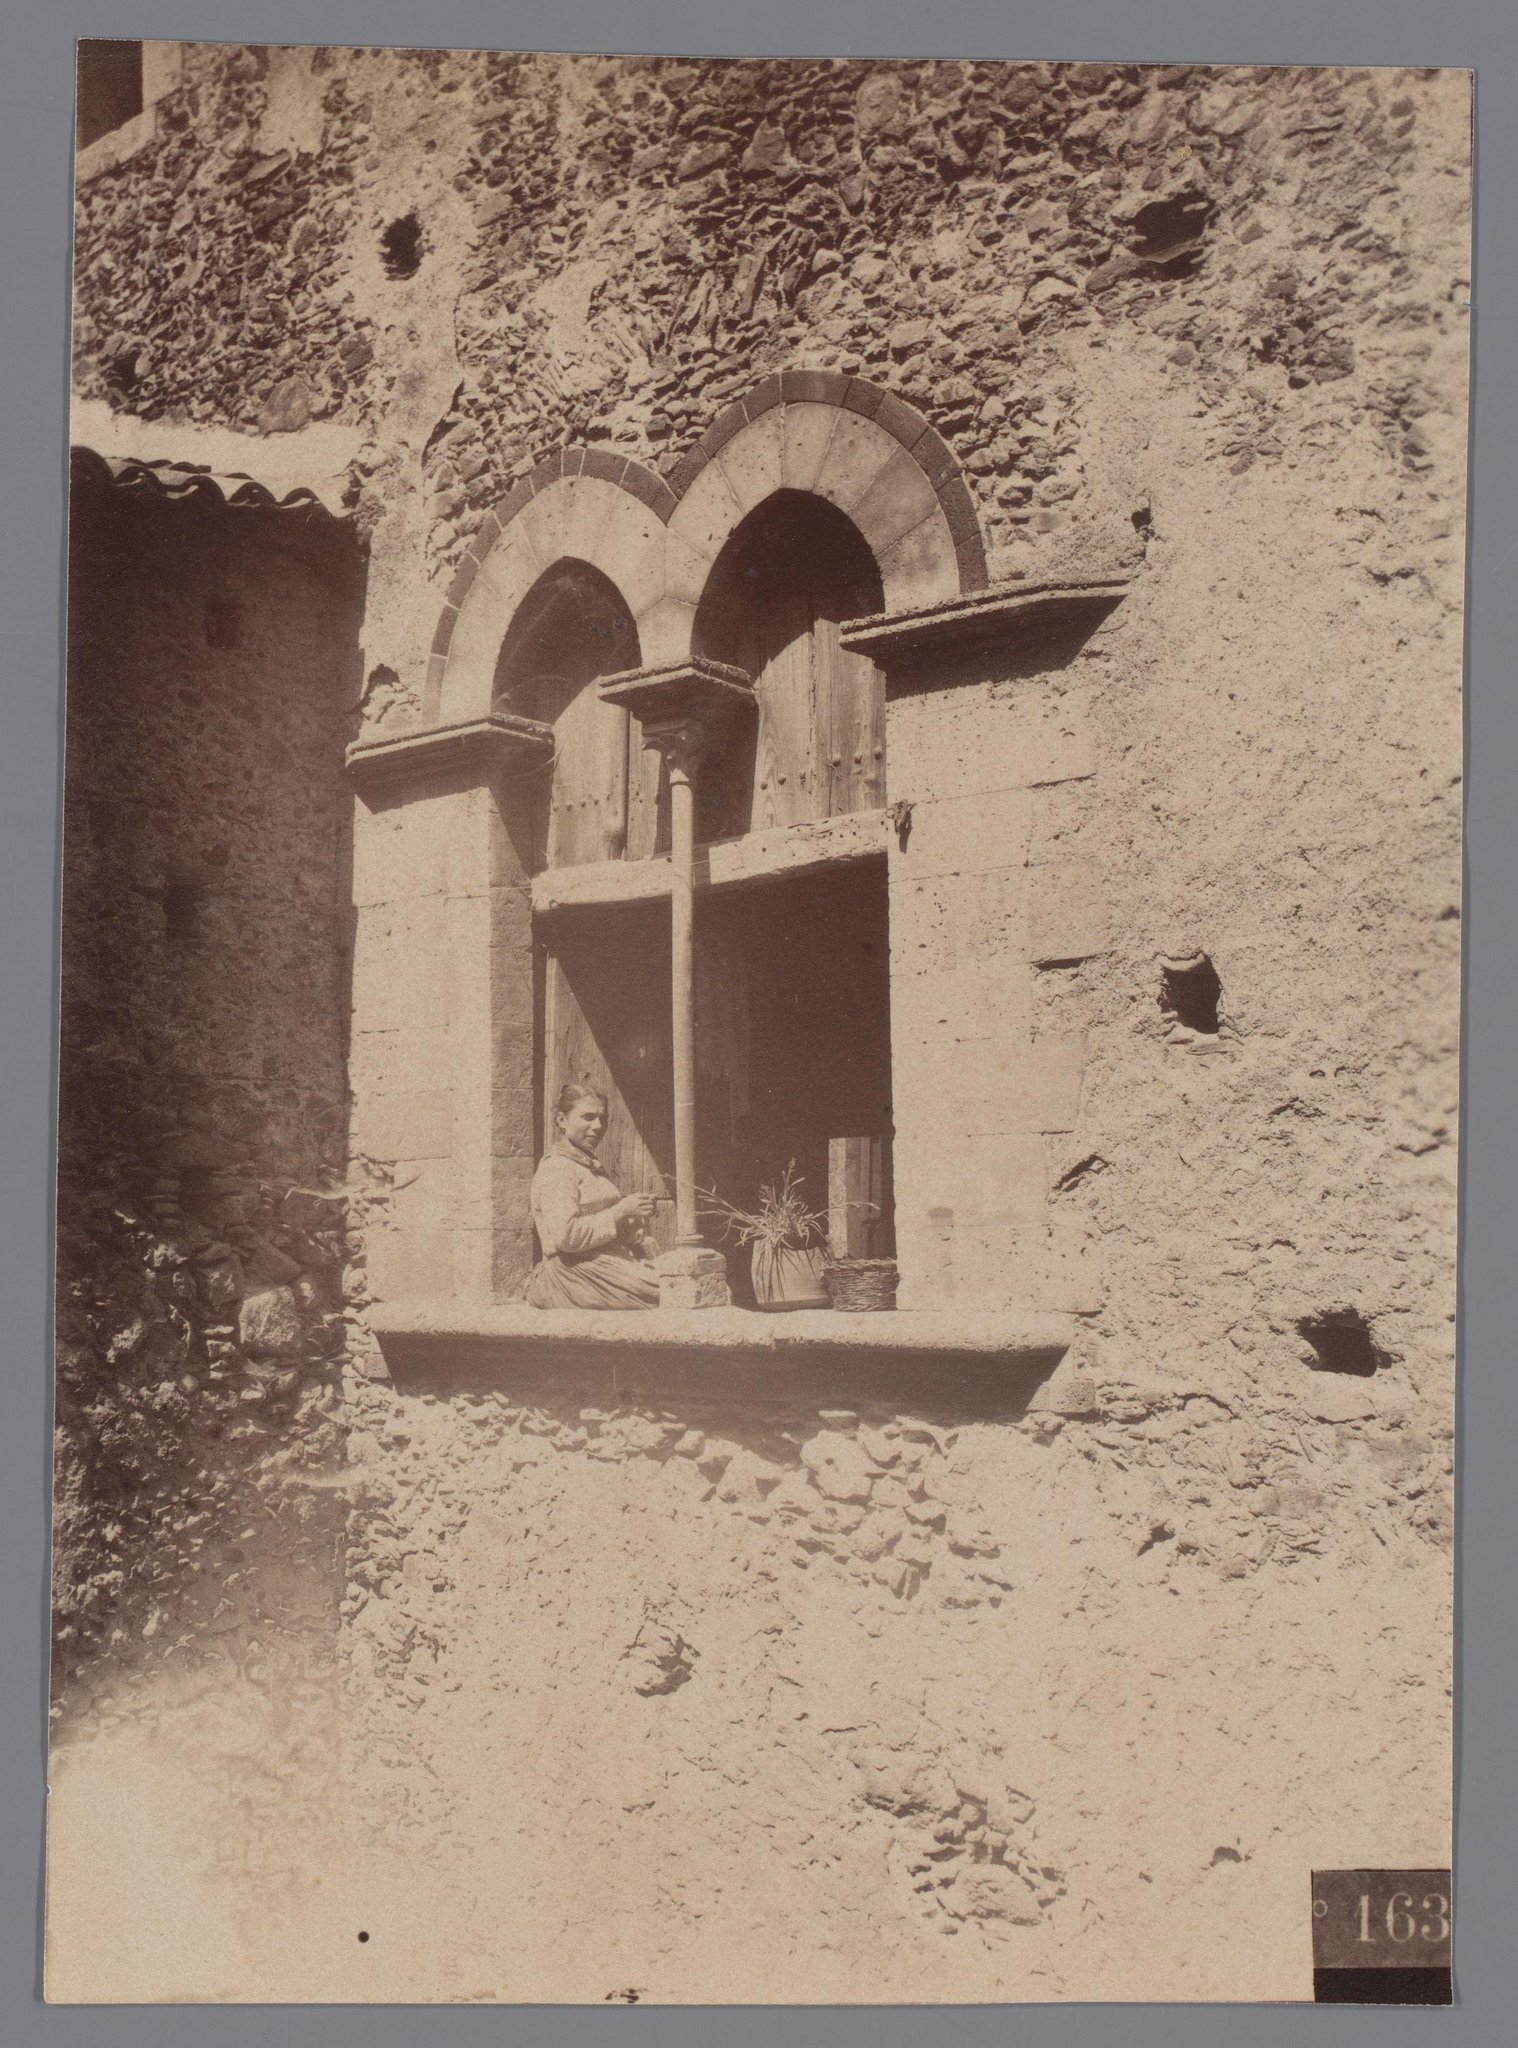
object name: photograph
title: Onbekende vrouw in een venster, vermoedelijk in Italië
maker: giovanni crupi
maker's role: fotograaf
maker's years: 1859-1925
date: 1865-1875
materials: paper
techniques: albumen print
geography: italy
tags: adult woman, open window, italy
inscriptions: number: ‘163’